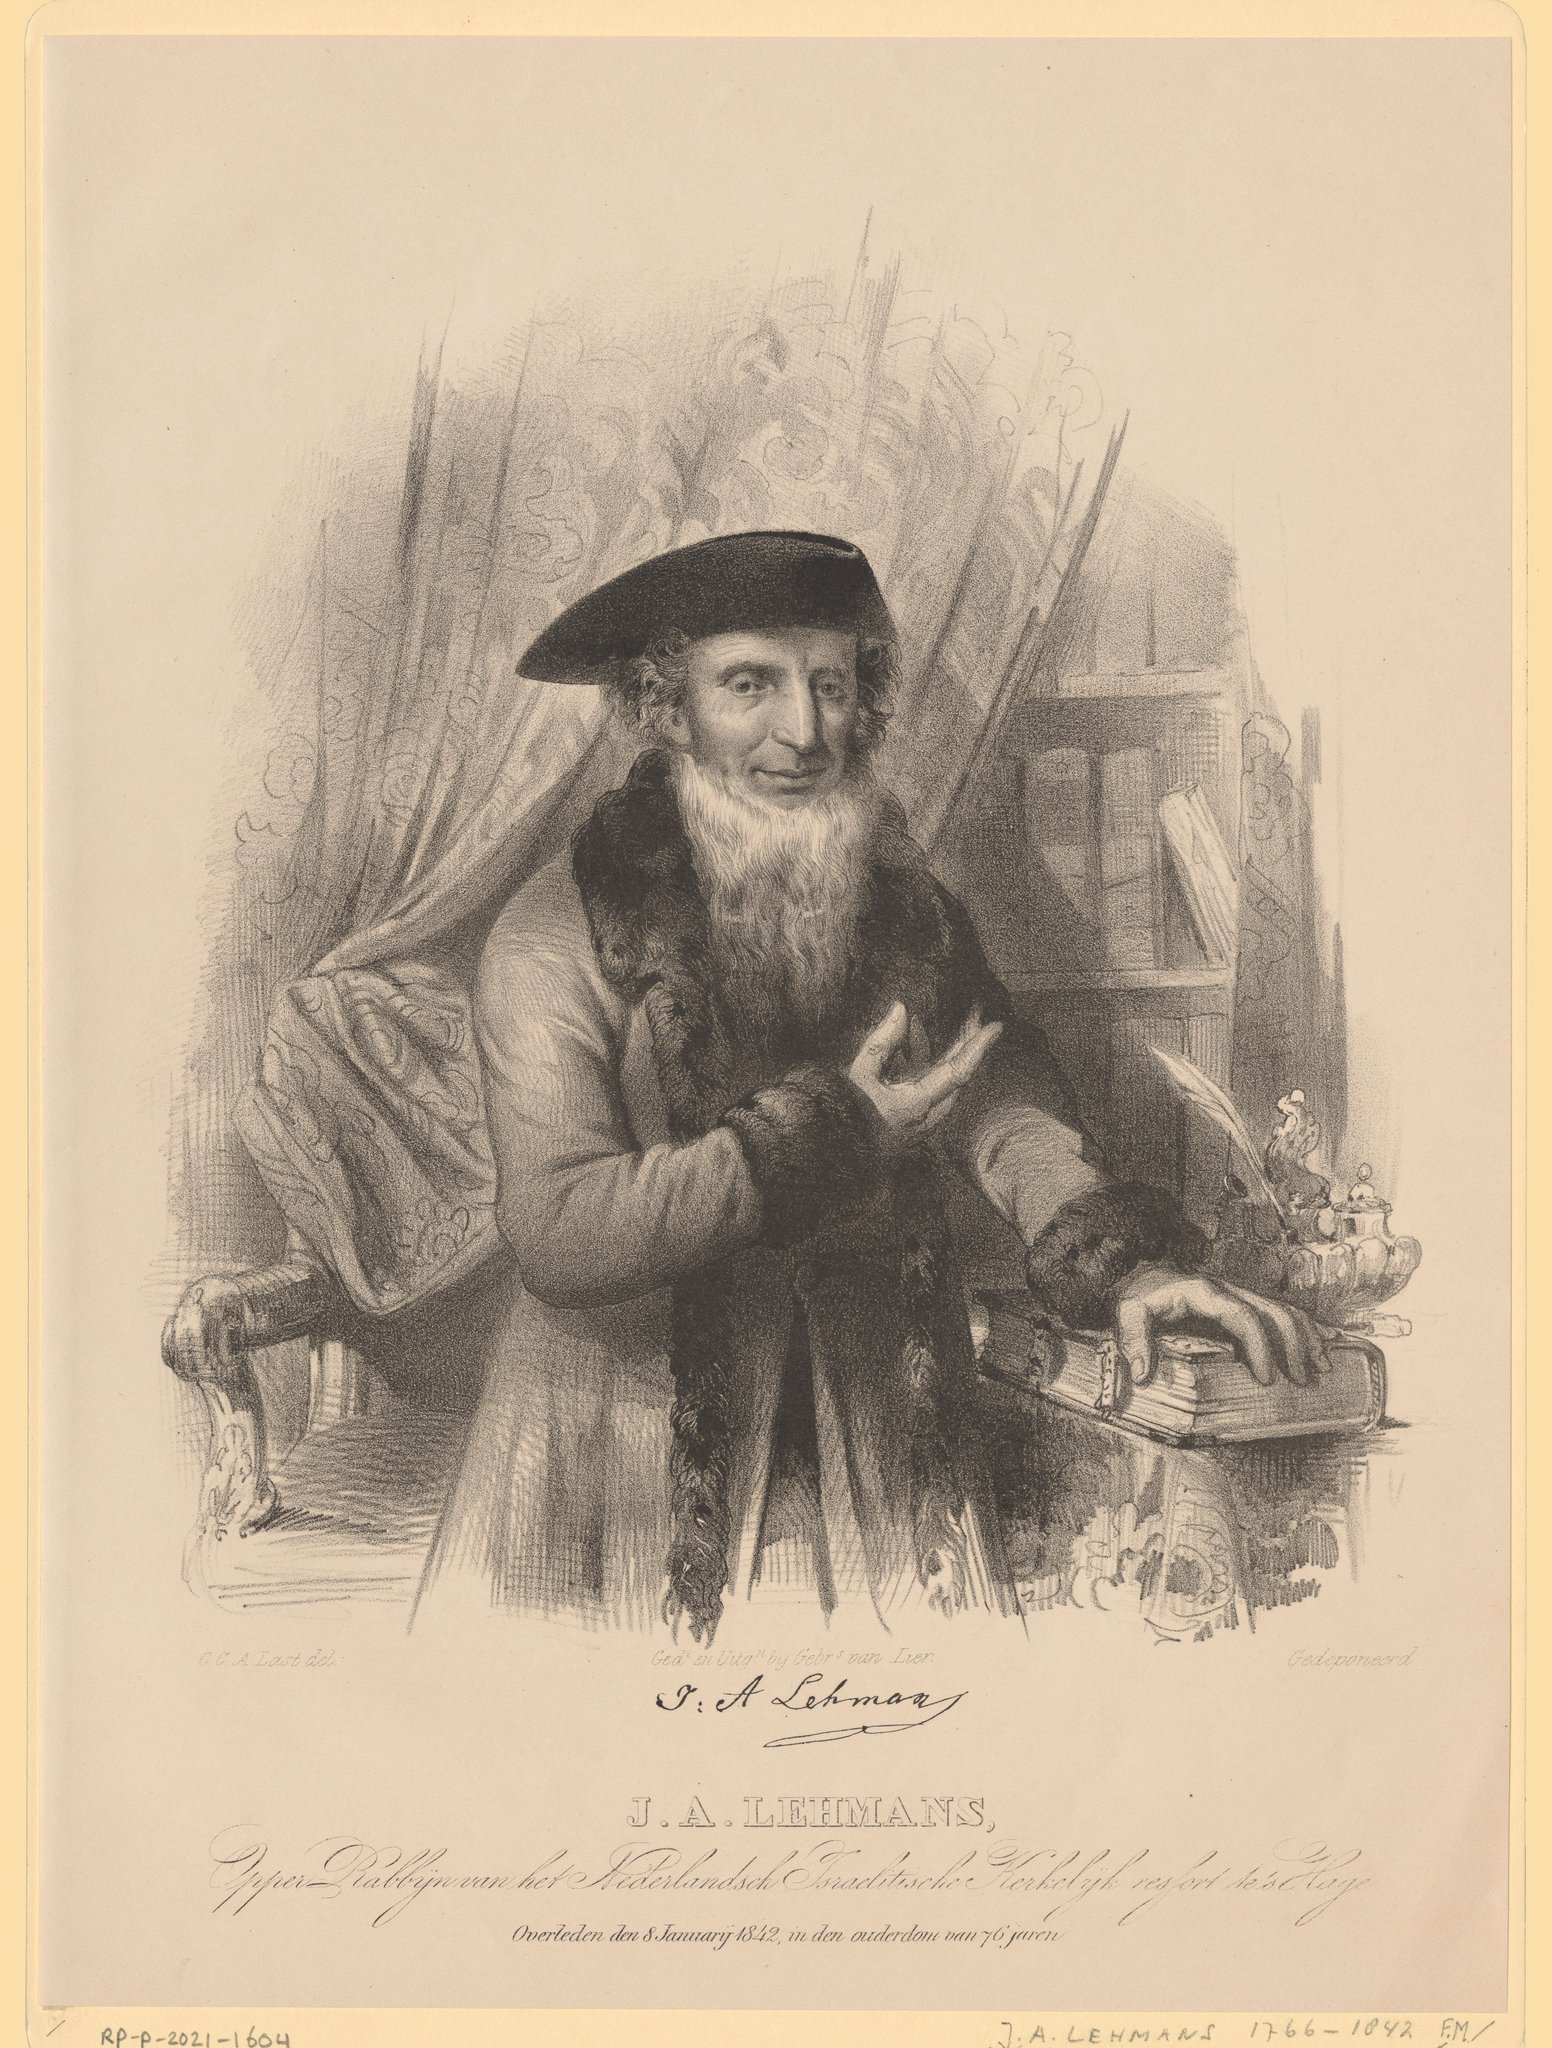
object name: print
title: Portret van Joseph Asser Lehmans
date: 1842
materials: paper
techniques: lithograph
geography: the hague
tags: amsterdam, the hague, bookshelves, writing tools, book, historical persons (+ half-length portrait), chief rabbi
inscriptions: : ‘Gedeponeerd.’